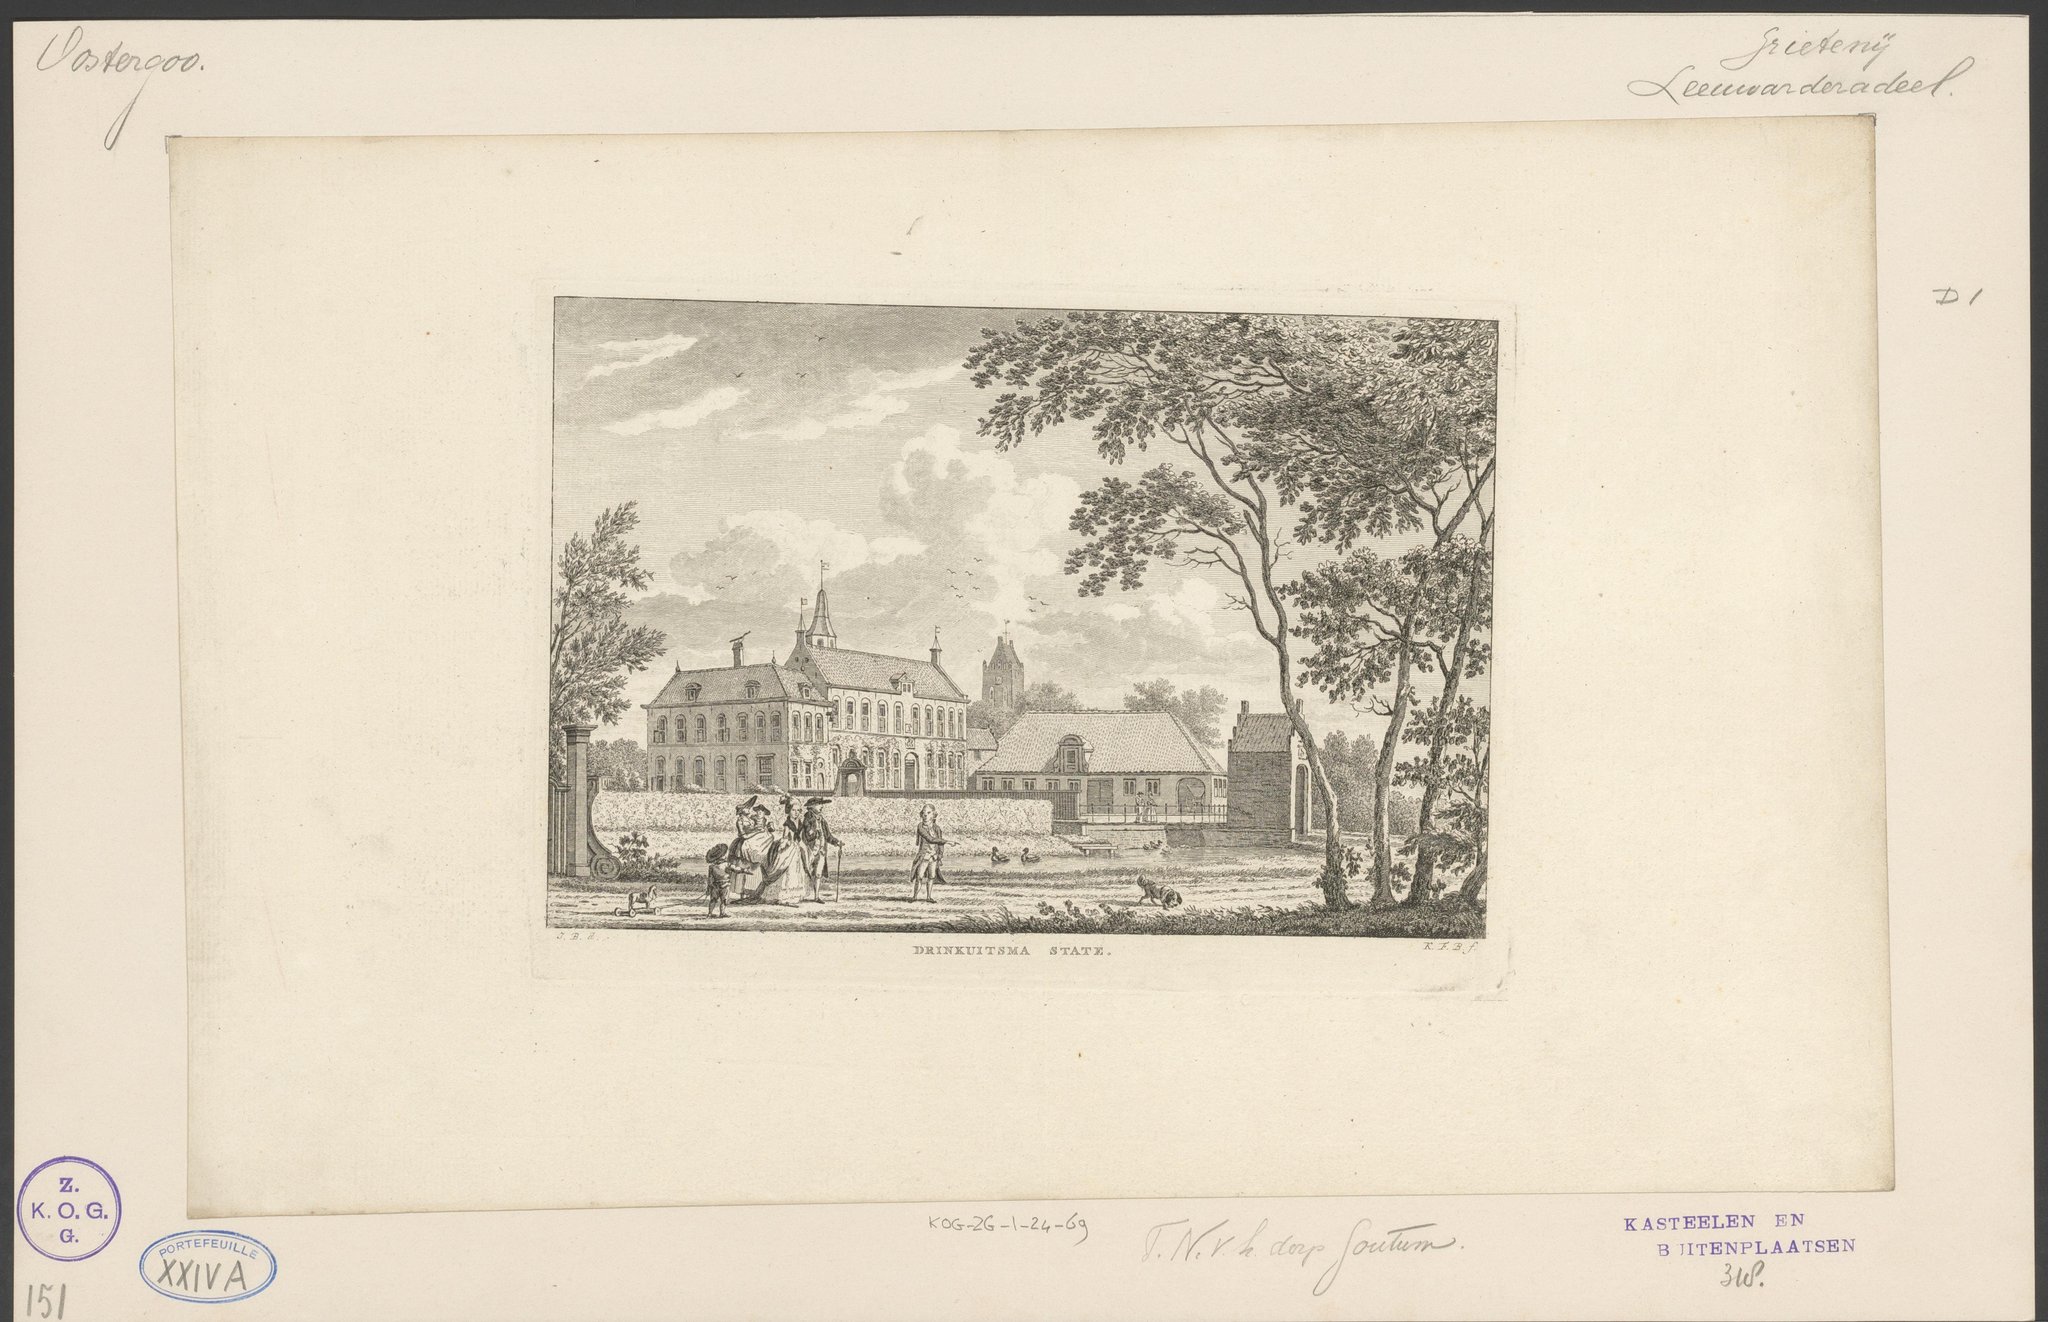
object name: print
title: Drinkuitsma State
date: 1786-1792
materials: paper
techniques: etching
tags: country-house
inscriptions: stamp, stamp, collector's mark: Lugt 1641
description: Prent uit: Vaderlandsche gezichten, of afbeeldingen van den tegenwoordigen staat der Vereenigde Nederlanden (…). Amsterdam: Hendrik Gartman, Willem Vermandel en Jan Willem Smit, 1786-1792. Uitgegeven in afleveringen met ieder een eigen bifolium en inhoudsopgave. Alle prenten in deze publicatie zijn gegraveerd door Carel Frederik Bendorp (I) en, in de meeste gevallen, gebaseerd op tekeningen van Jan Bulthuis. Het opschrift vermeldt een andere benaming voor de Eminga State, Drinkuitsma State (zie http://www.stinseninfriesland.nl).